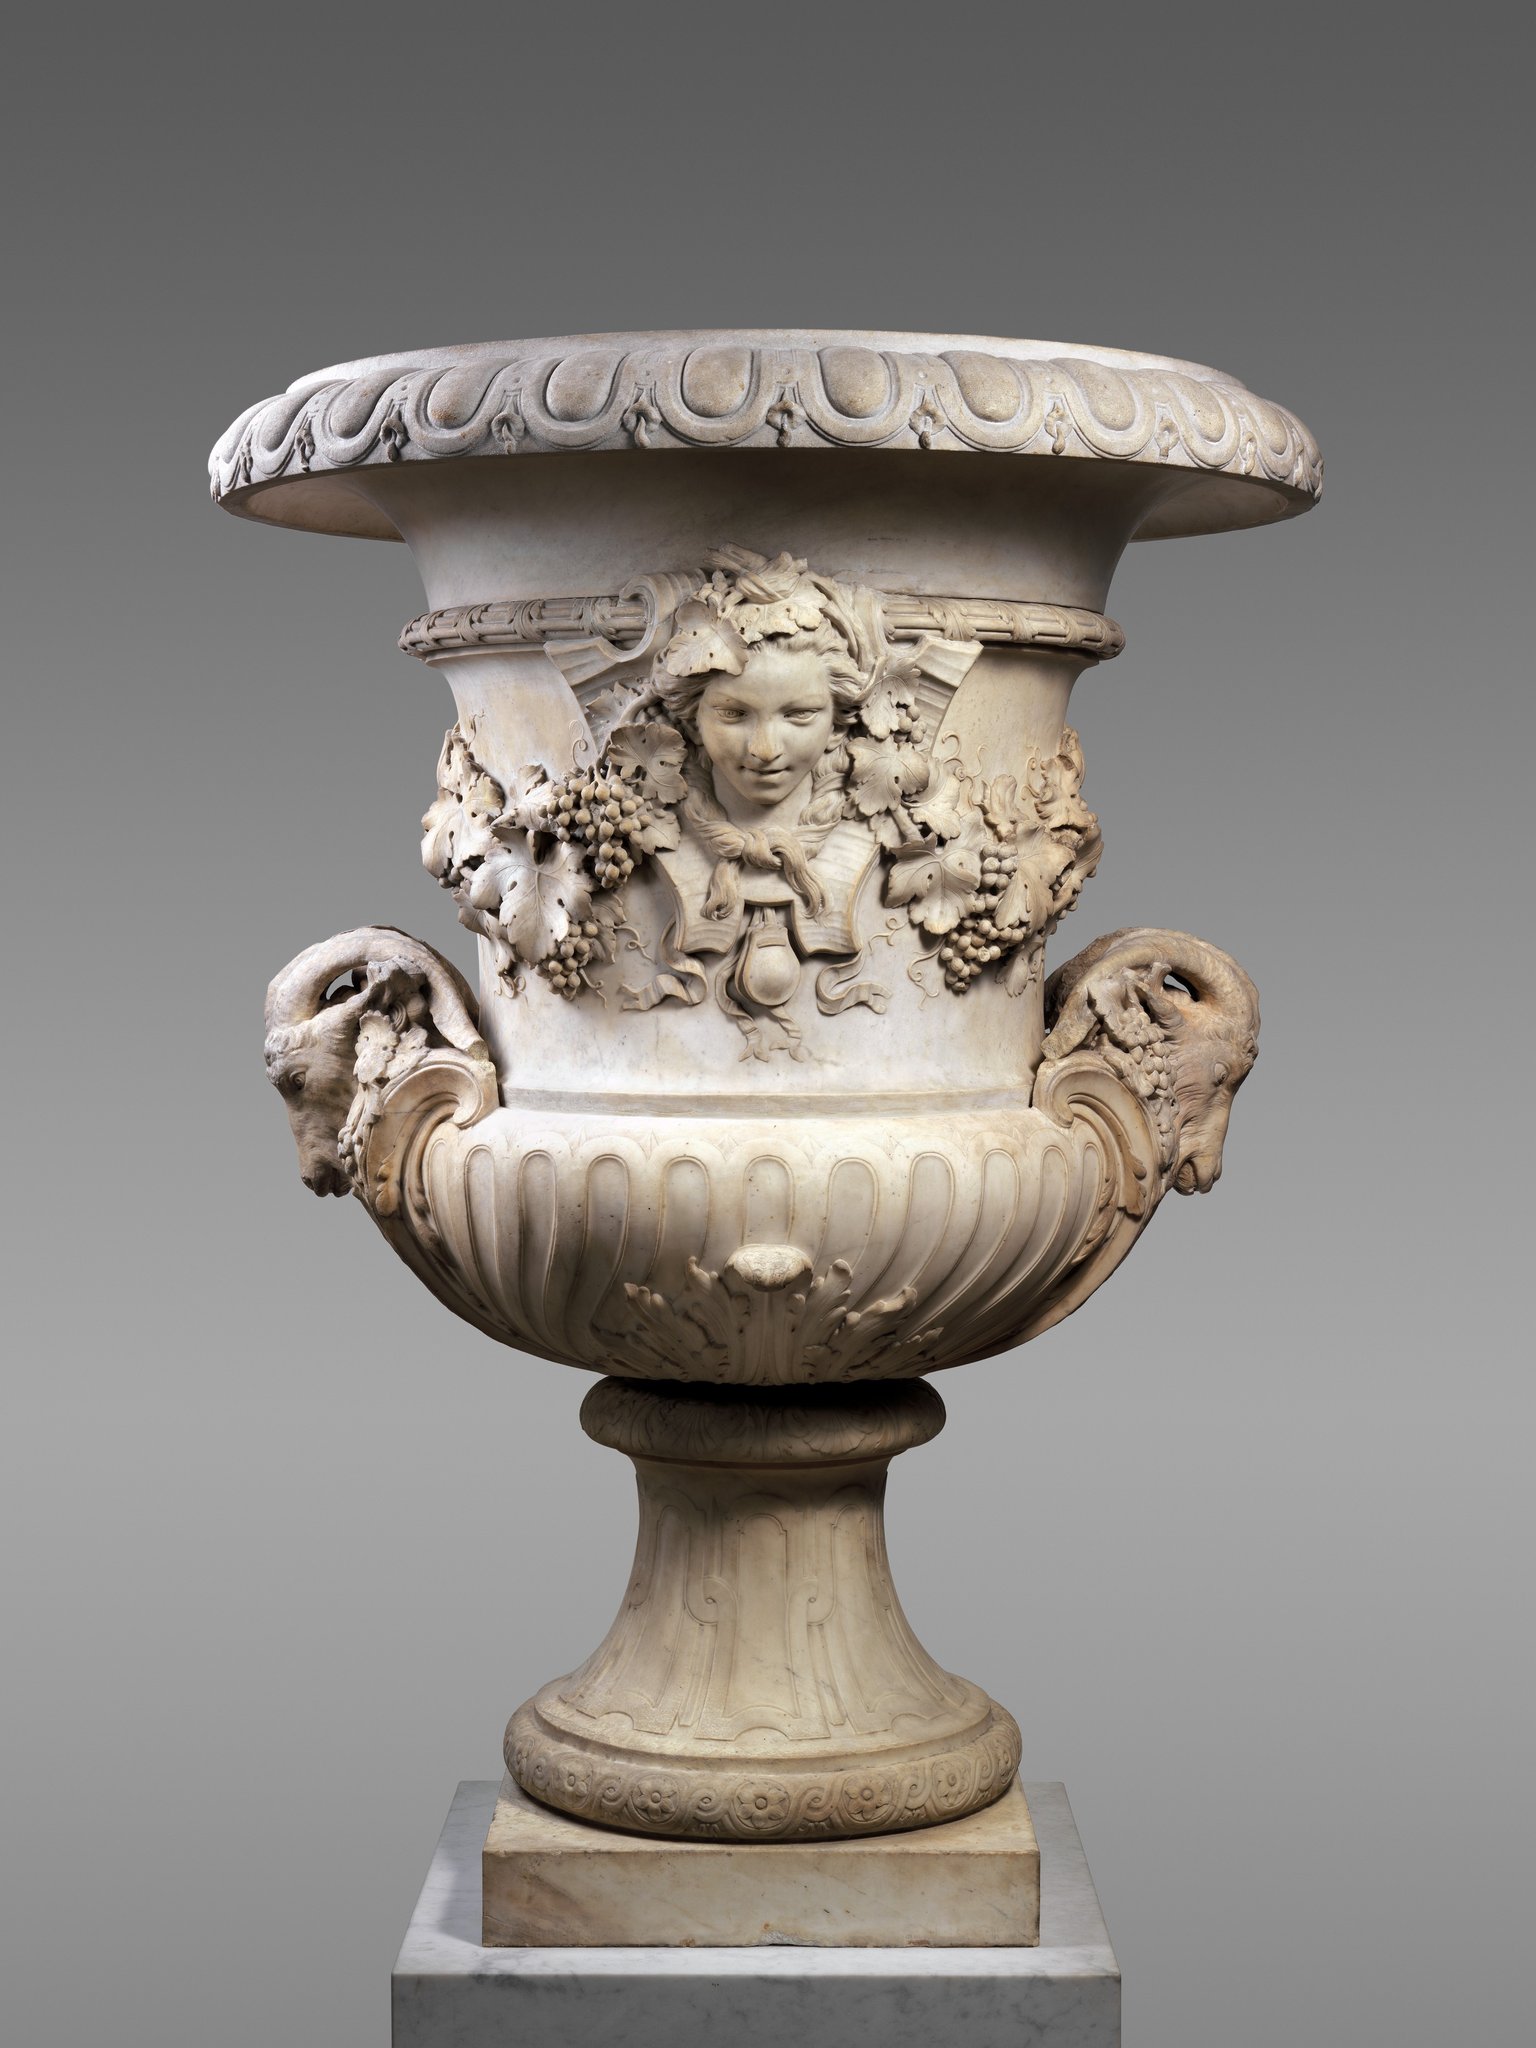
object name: vase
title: Autumn (one of a pair)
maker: jean-baptiste pigalle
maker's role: artist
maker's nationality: french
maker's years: 1714-1785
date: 1742-1745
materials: marble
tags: animals,grapes,faces